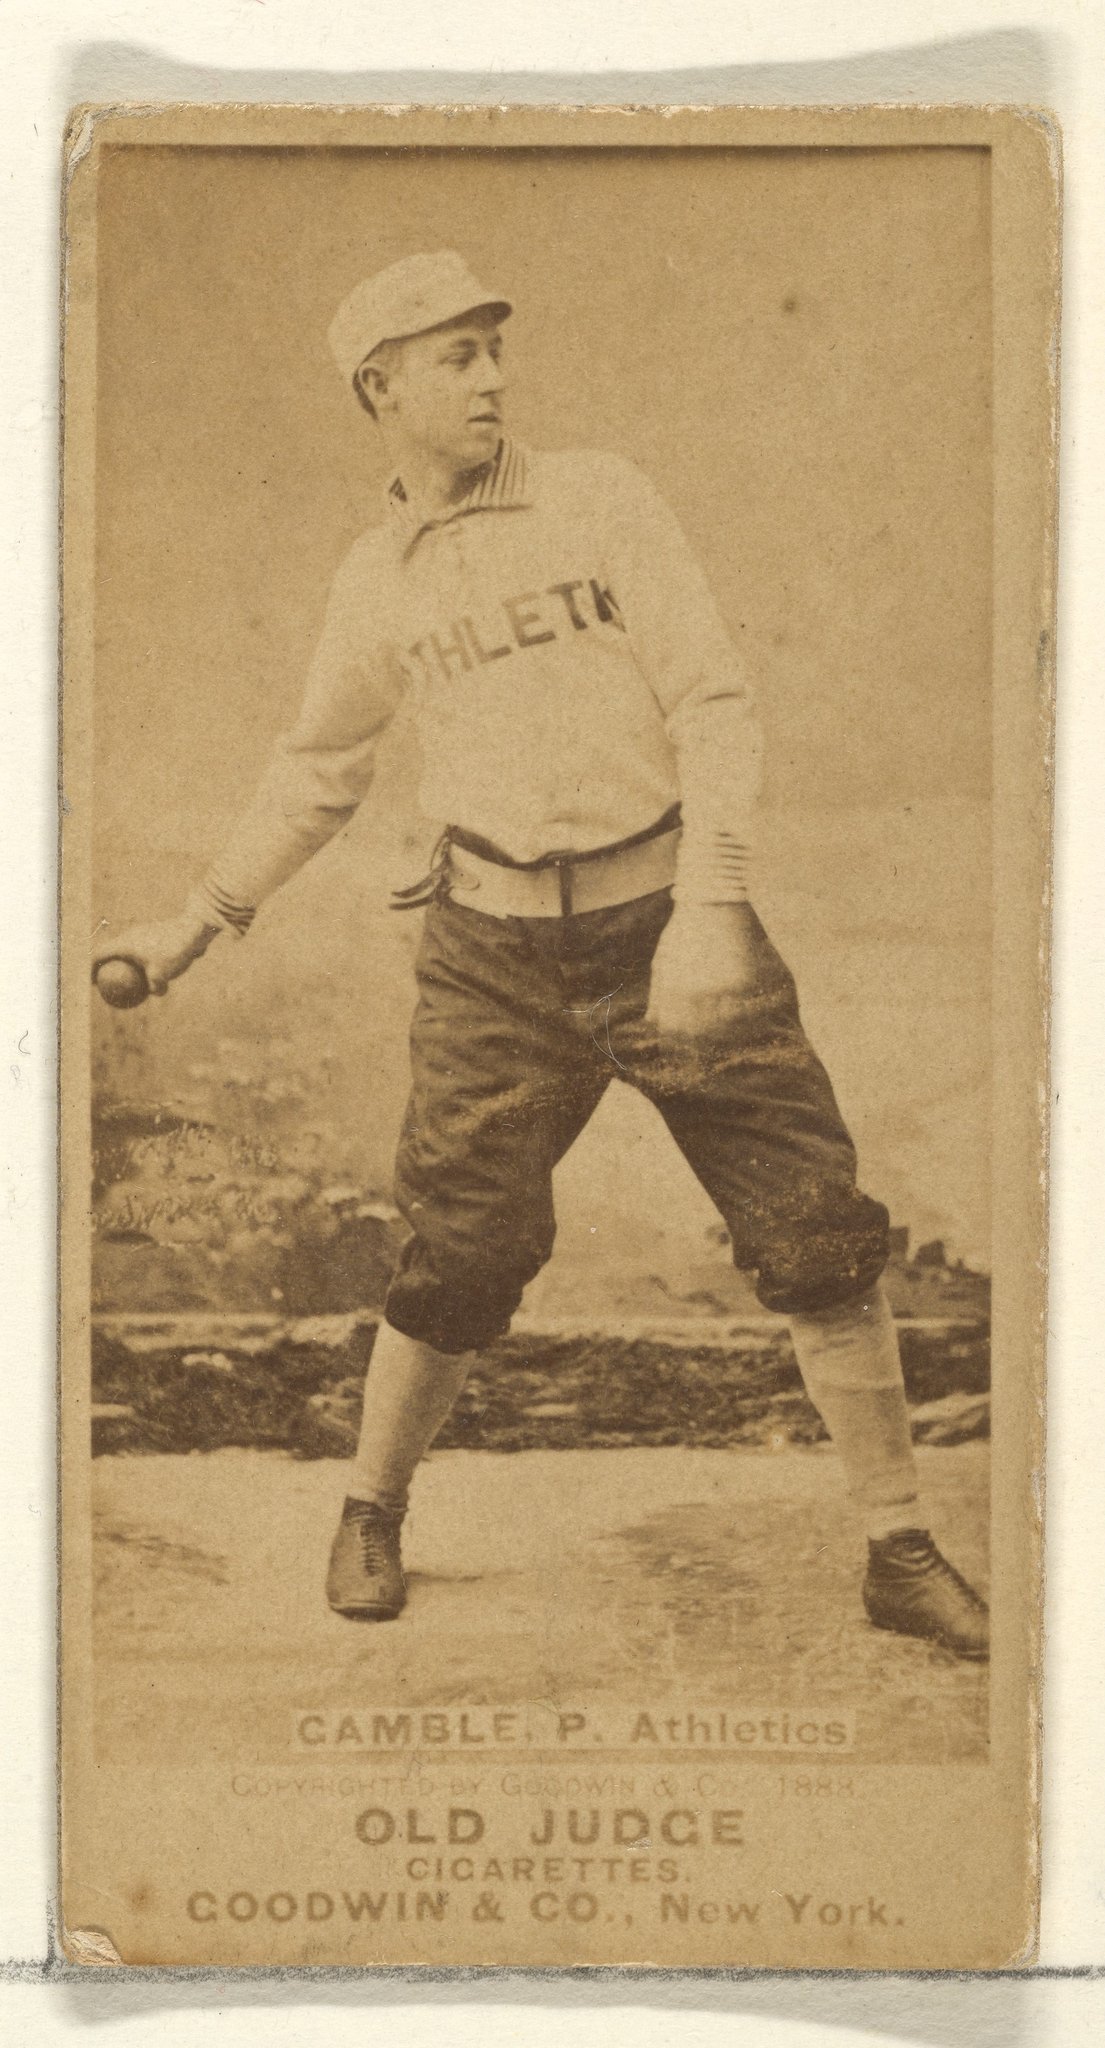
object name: baseball card, photograph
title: Gamble, Pitcher, Philadelphia Athletics, from the Old Judge series (N172) for Old Judge Cigarettes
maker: goodwin & company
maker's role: publisher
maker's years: 1850-1950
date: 1888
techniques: albumen silver print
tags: men,portraits,baseball,athletes